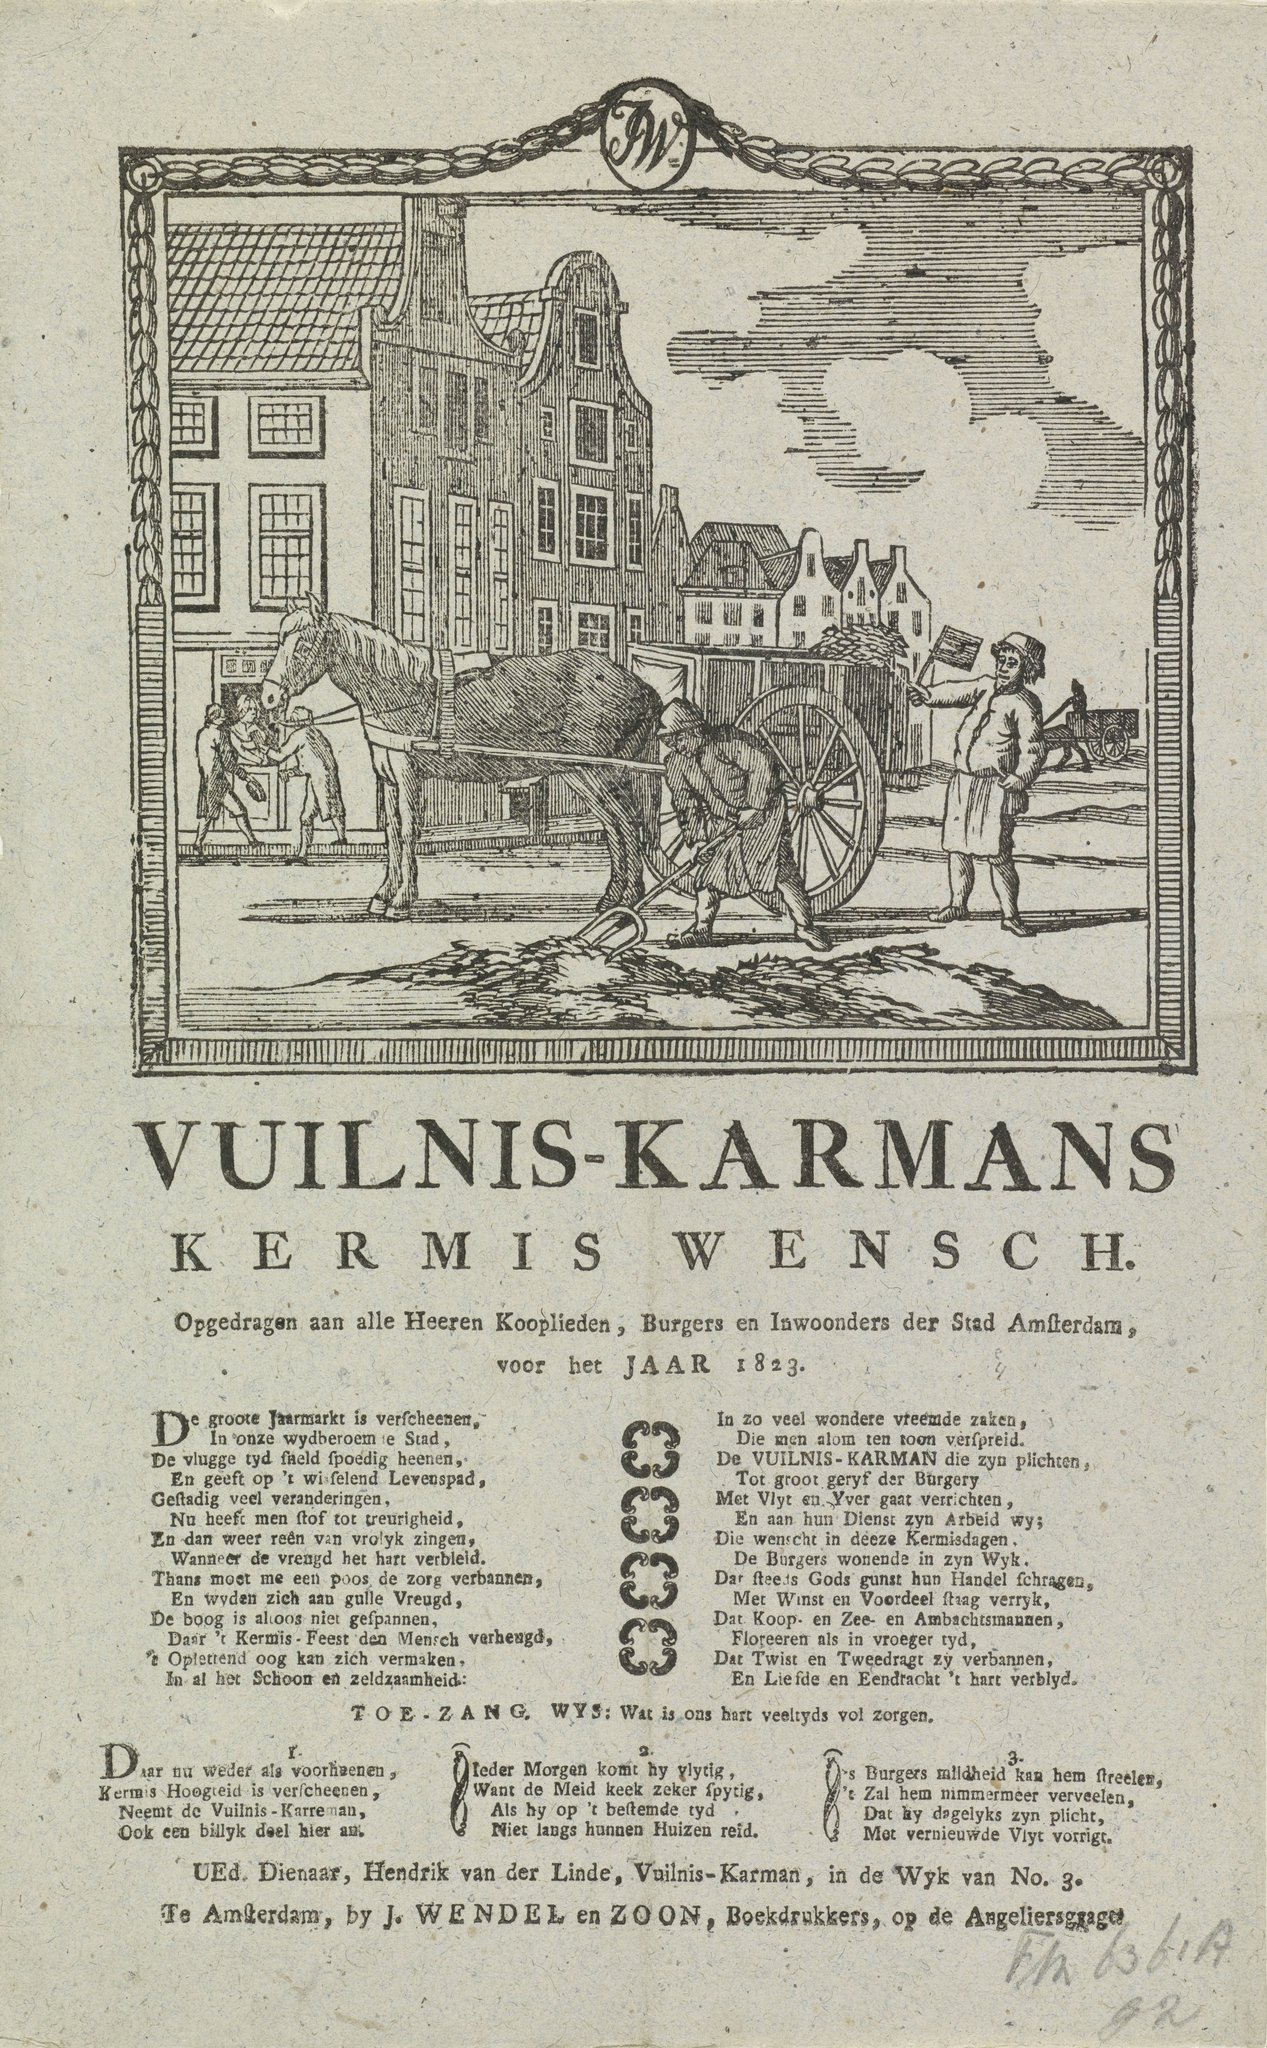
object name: print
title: Kermisprent van de vuilnismannen van Amsterdam voor het jaar 1823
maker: Anonymous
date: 1823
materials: paper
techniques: letterpress printing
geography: amsterdam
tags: street, garbage collection, amsterdam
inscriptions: collector's mark: Lugt 2228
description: Kermisprent van de Amsterdamse vuilnismannen voor het jaar 1823. Gezicht in een straat te Amsterdam waar een man met een kar vuil van straat schept, bij hem een man met een ratel. Twee andere mannen halen bij een huis geld op. Met gedicht in twee kolommen en een lied in drie verzen. Van de vuilniskarman in de wijk no. 3: Hendrik van der Linde.